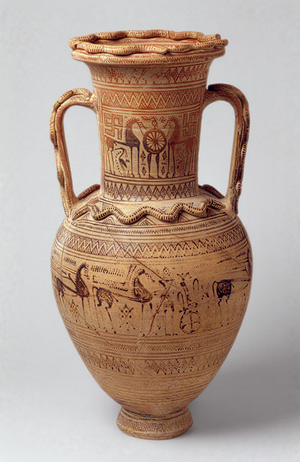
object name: neck amphora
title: Terracotta neck-amphora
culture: greek, attic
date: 710 BCE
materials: terracotta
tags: birds,horses,chariots